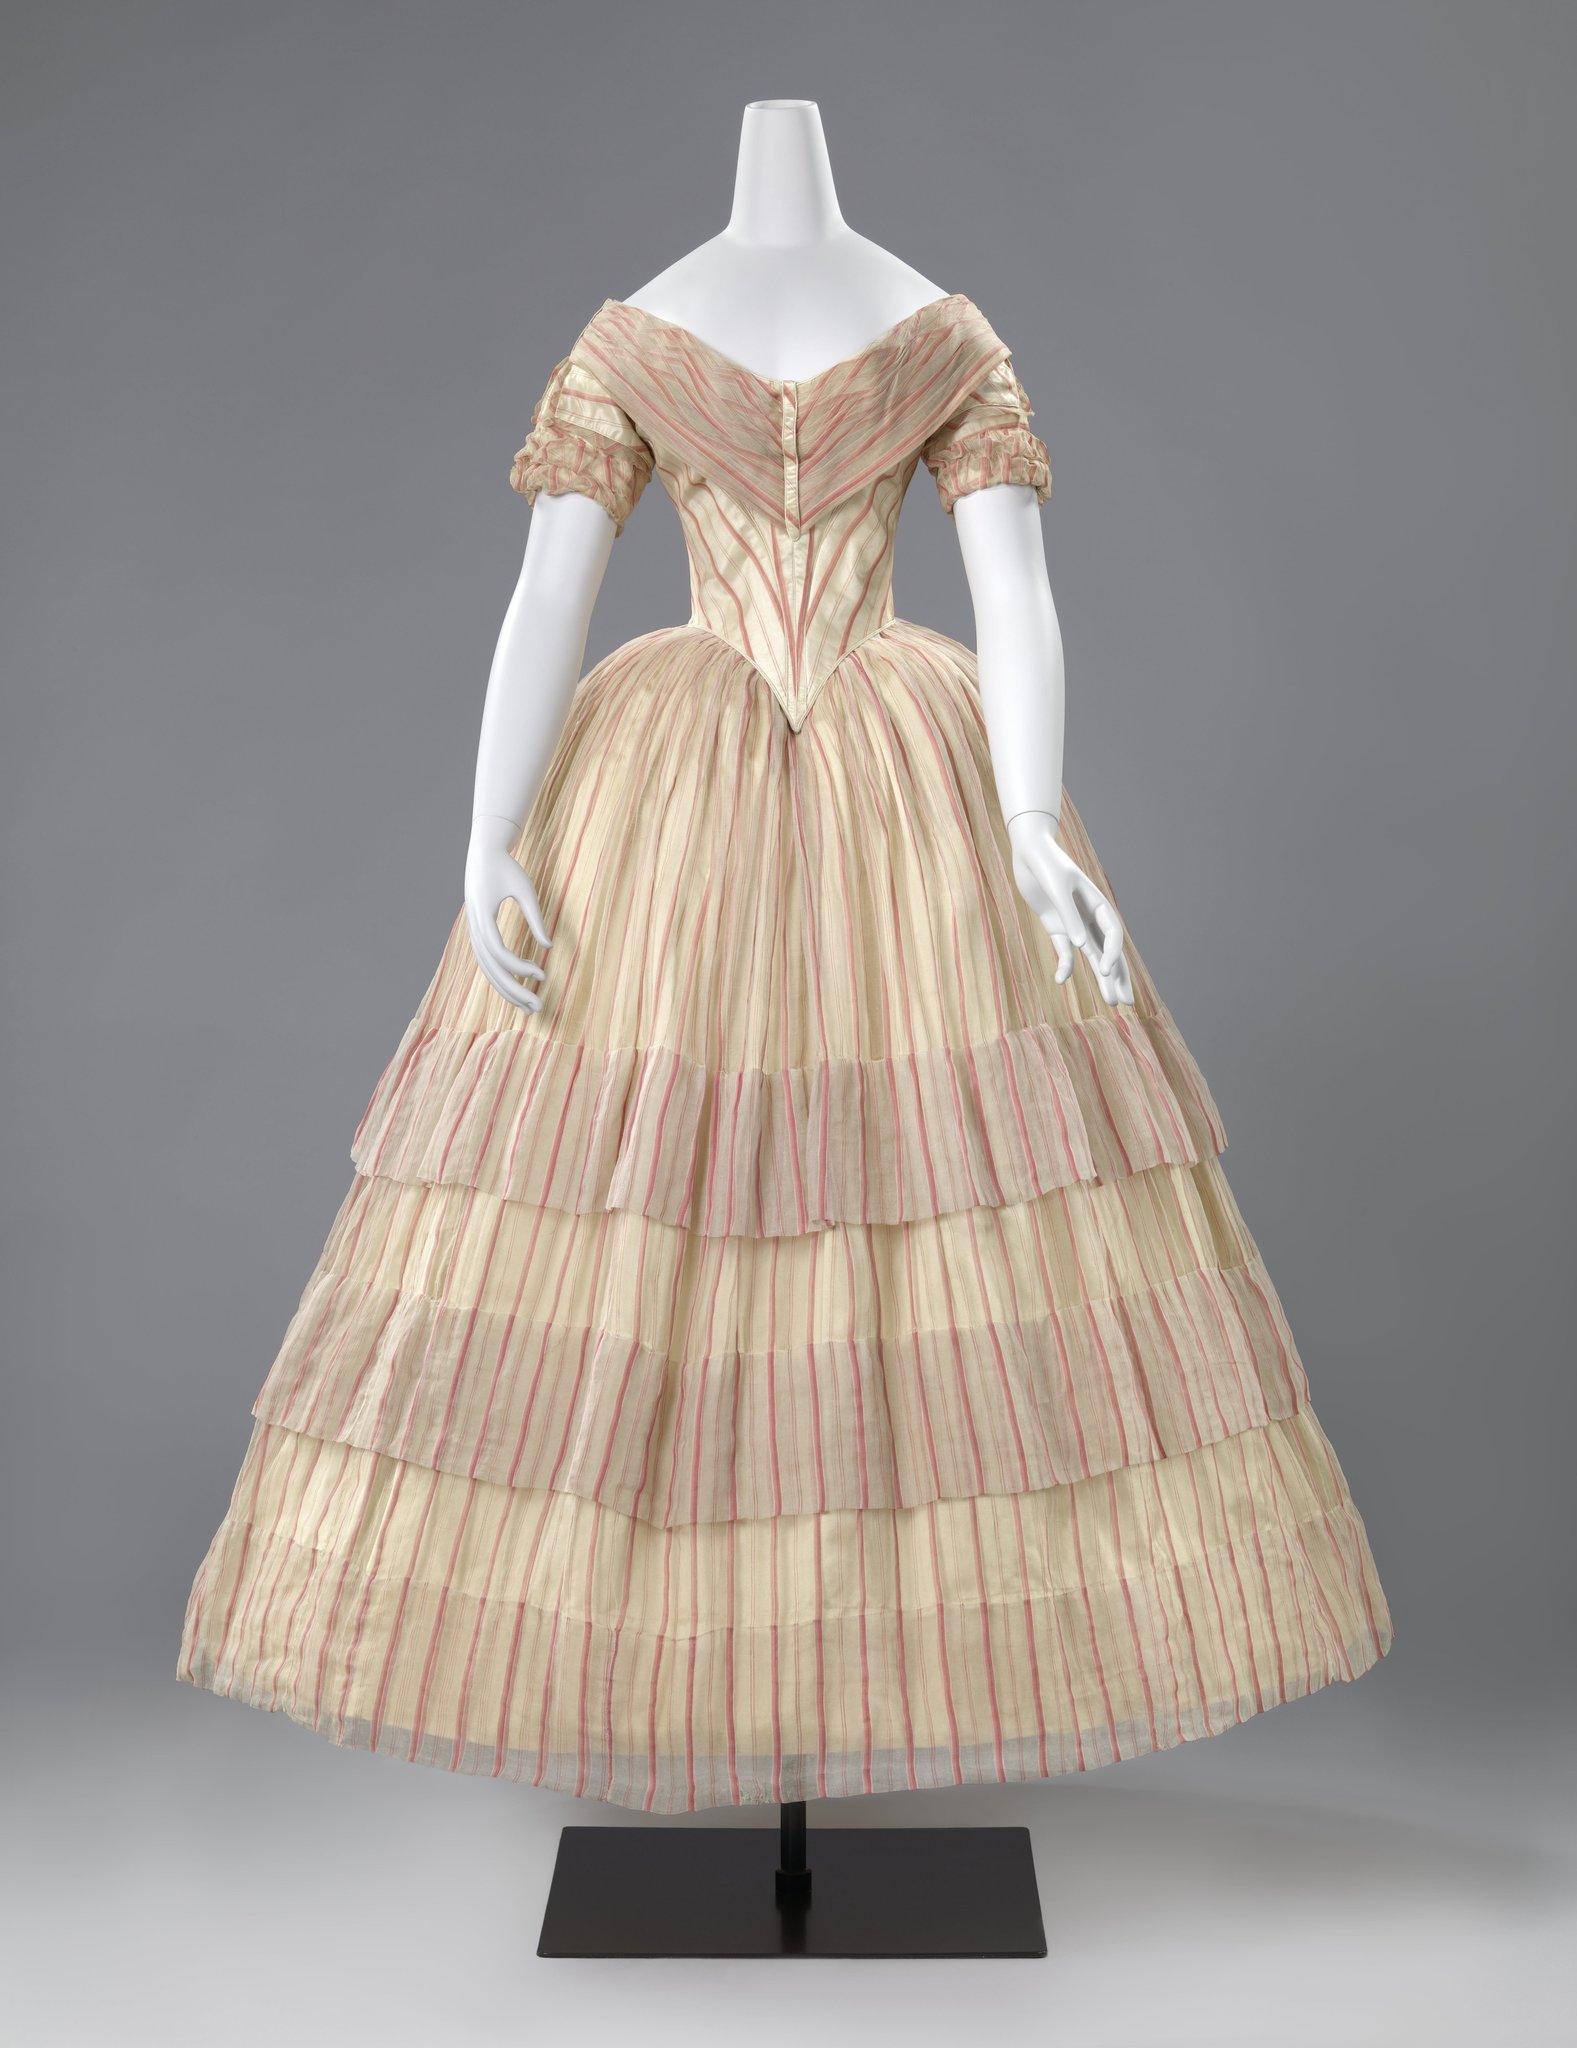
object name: childrenswear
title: Full Evening Dress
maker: Anonymous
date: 1850-1856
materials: cotton, metal, textile, silk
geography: netherlands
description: The boat neck was reserved for eveningwear. Day dresses were higher-necked and usually had long sleeves. The pointed bodice of this dress is fitted with whalebones, and a medium-size crinoline (hooped petticoat) was worn under the skirt. The striped fabric, which became fashionable around 1855, is incorporated into the design both horizontally and vertically.